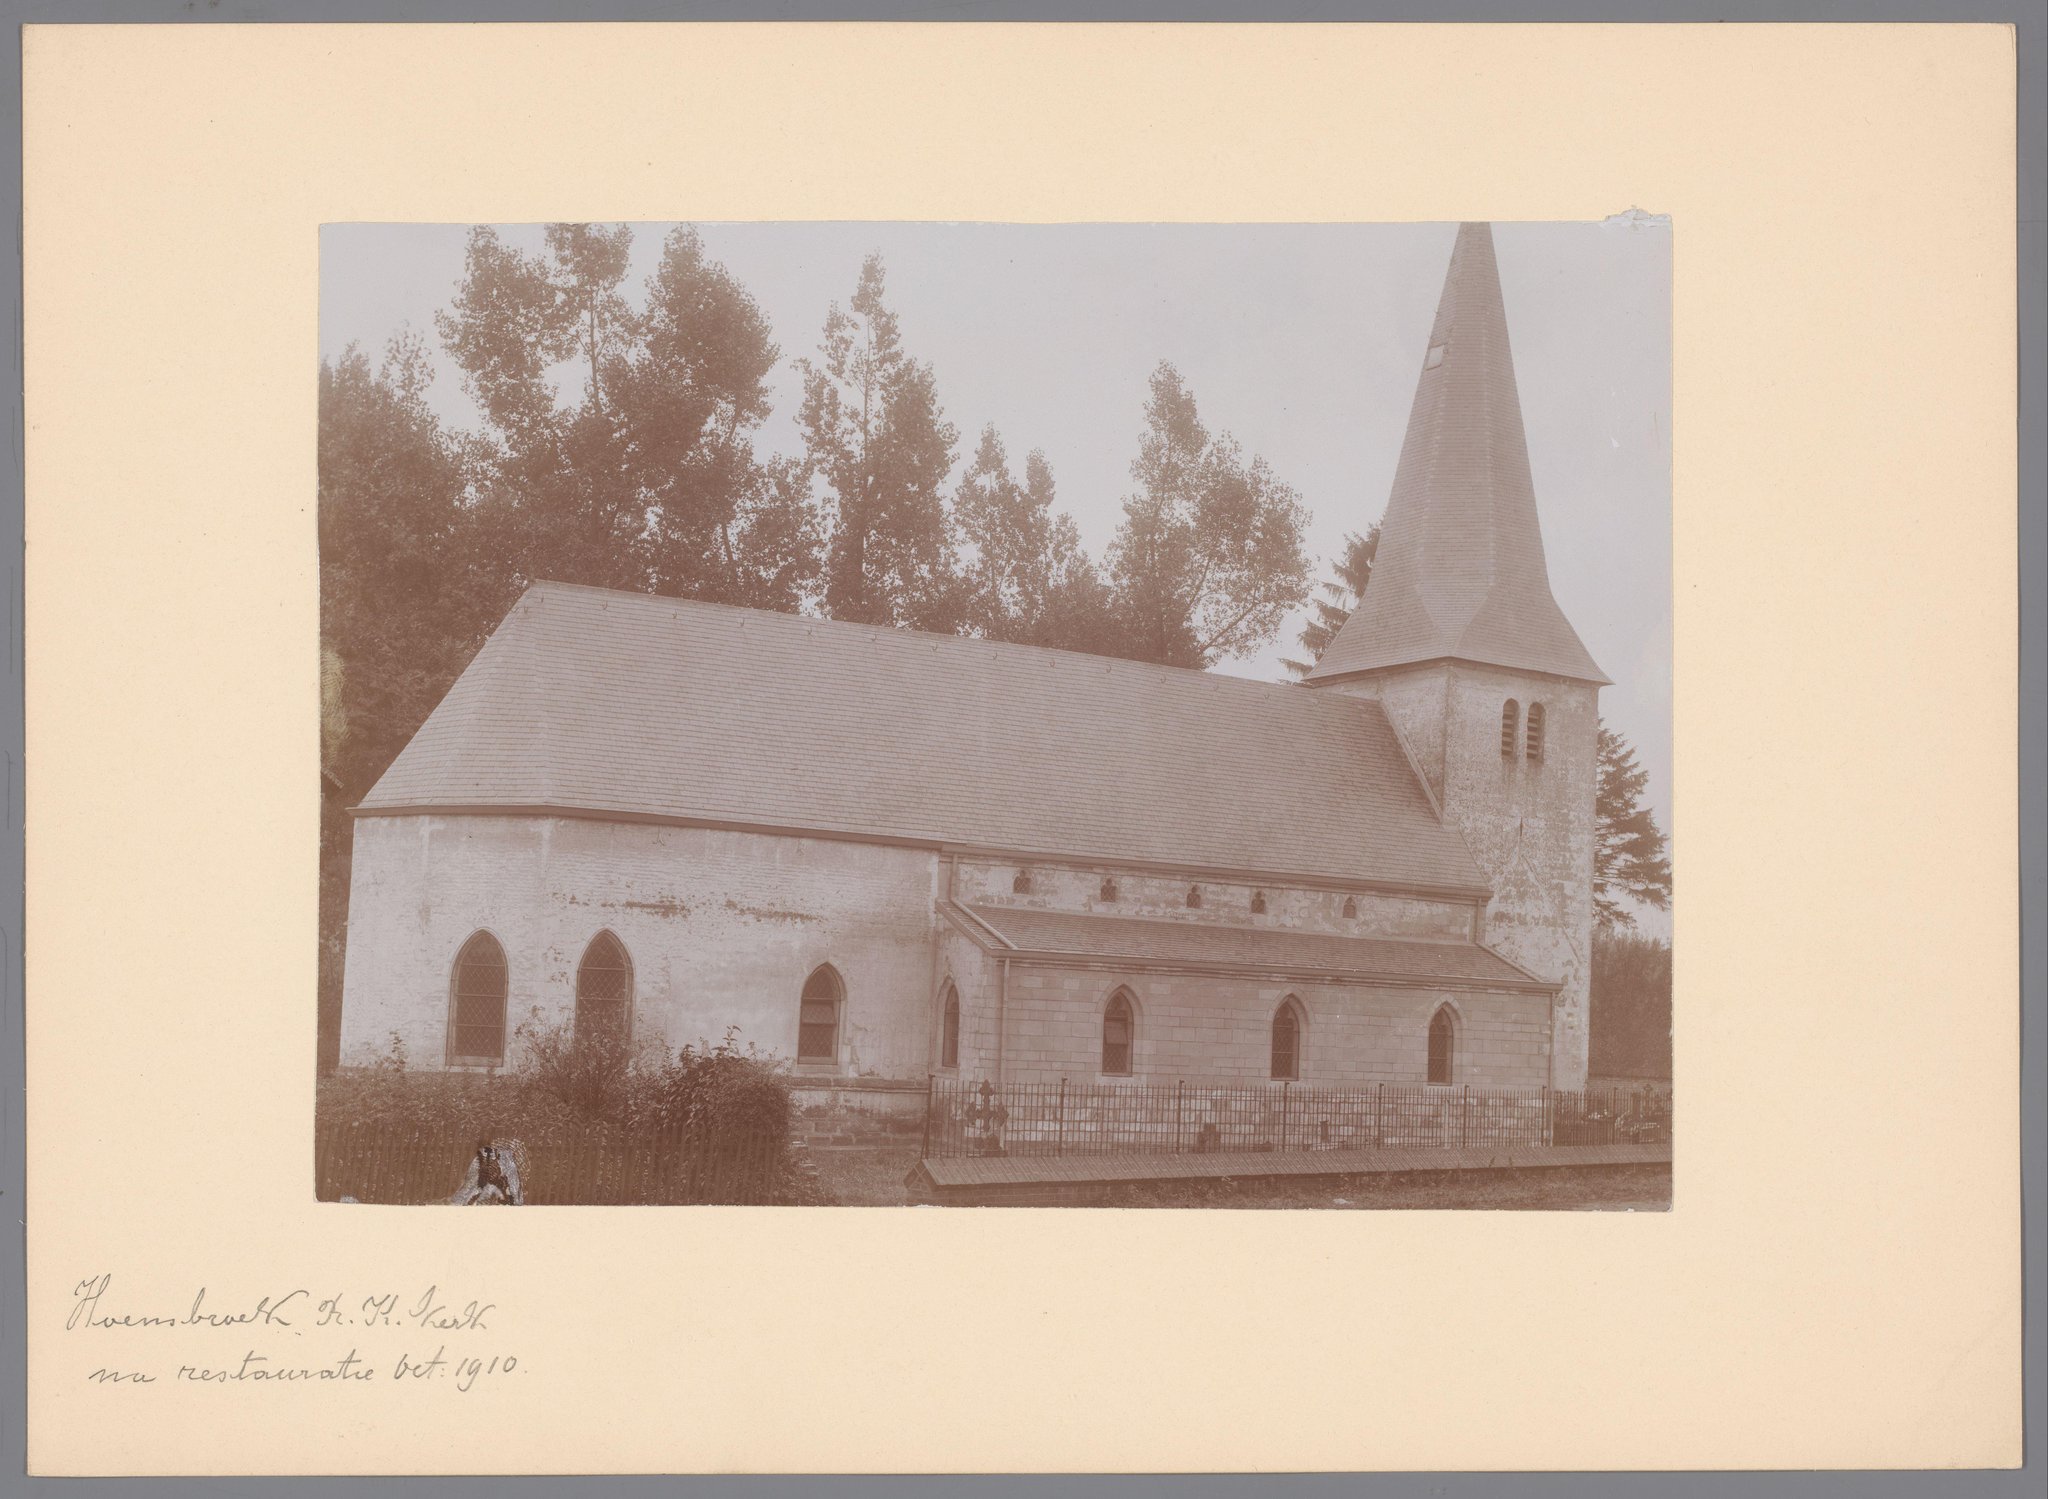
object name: photograph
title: Noordzijde van de Sint-Janskerk te Hoensbroek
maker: anoniem (monumentenzorg)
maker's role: fotograaf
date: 1910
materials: cardboard, photographic support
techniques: collodion silver print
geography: hoensbroek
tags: church (exterior)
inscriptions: annotation: ‘Hoensbroek R.K. Kerk/ na restauratie oct 1910’